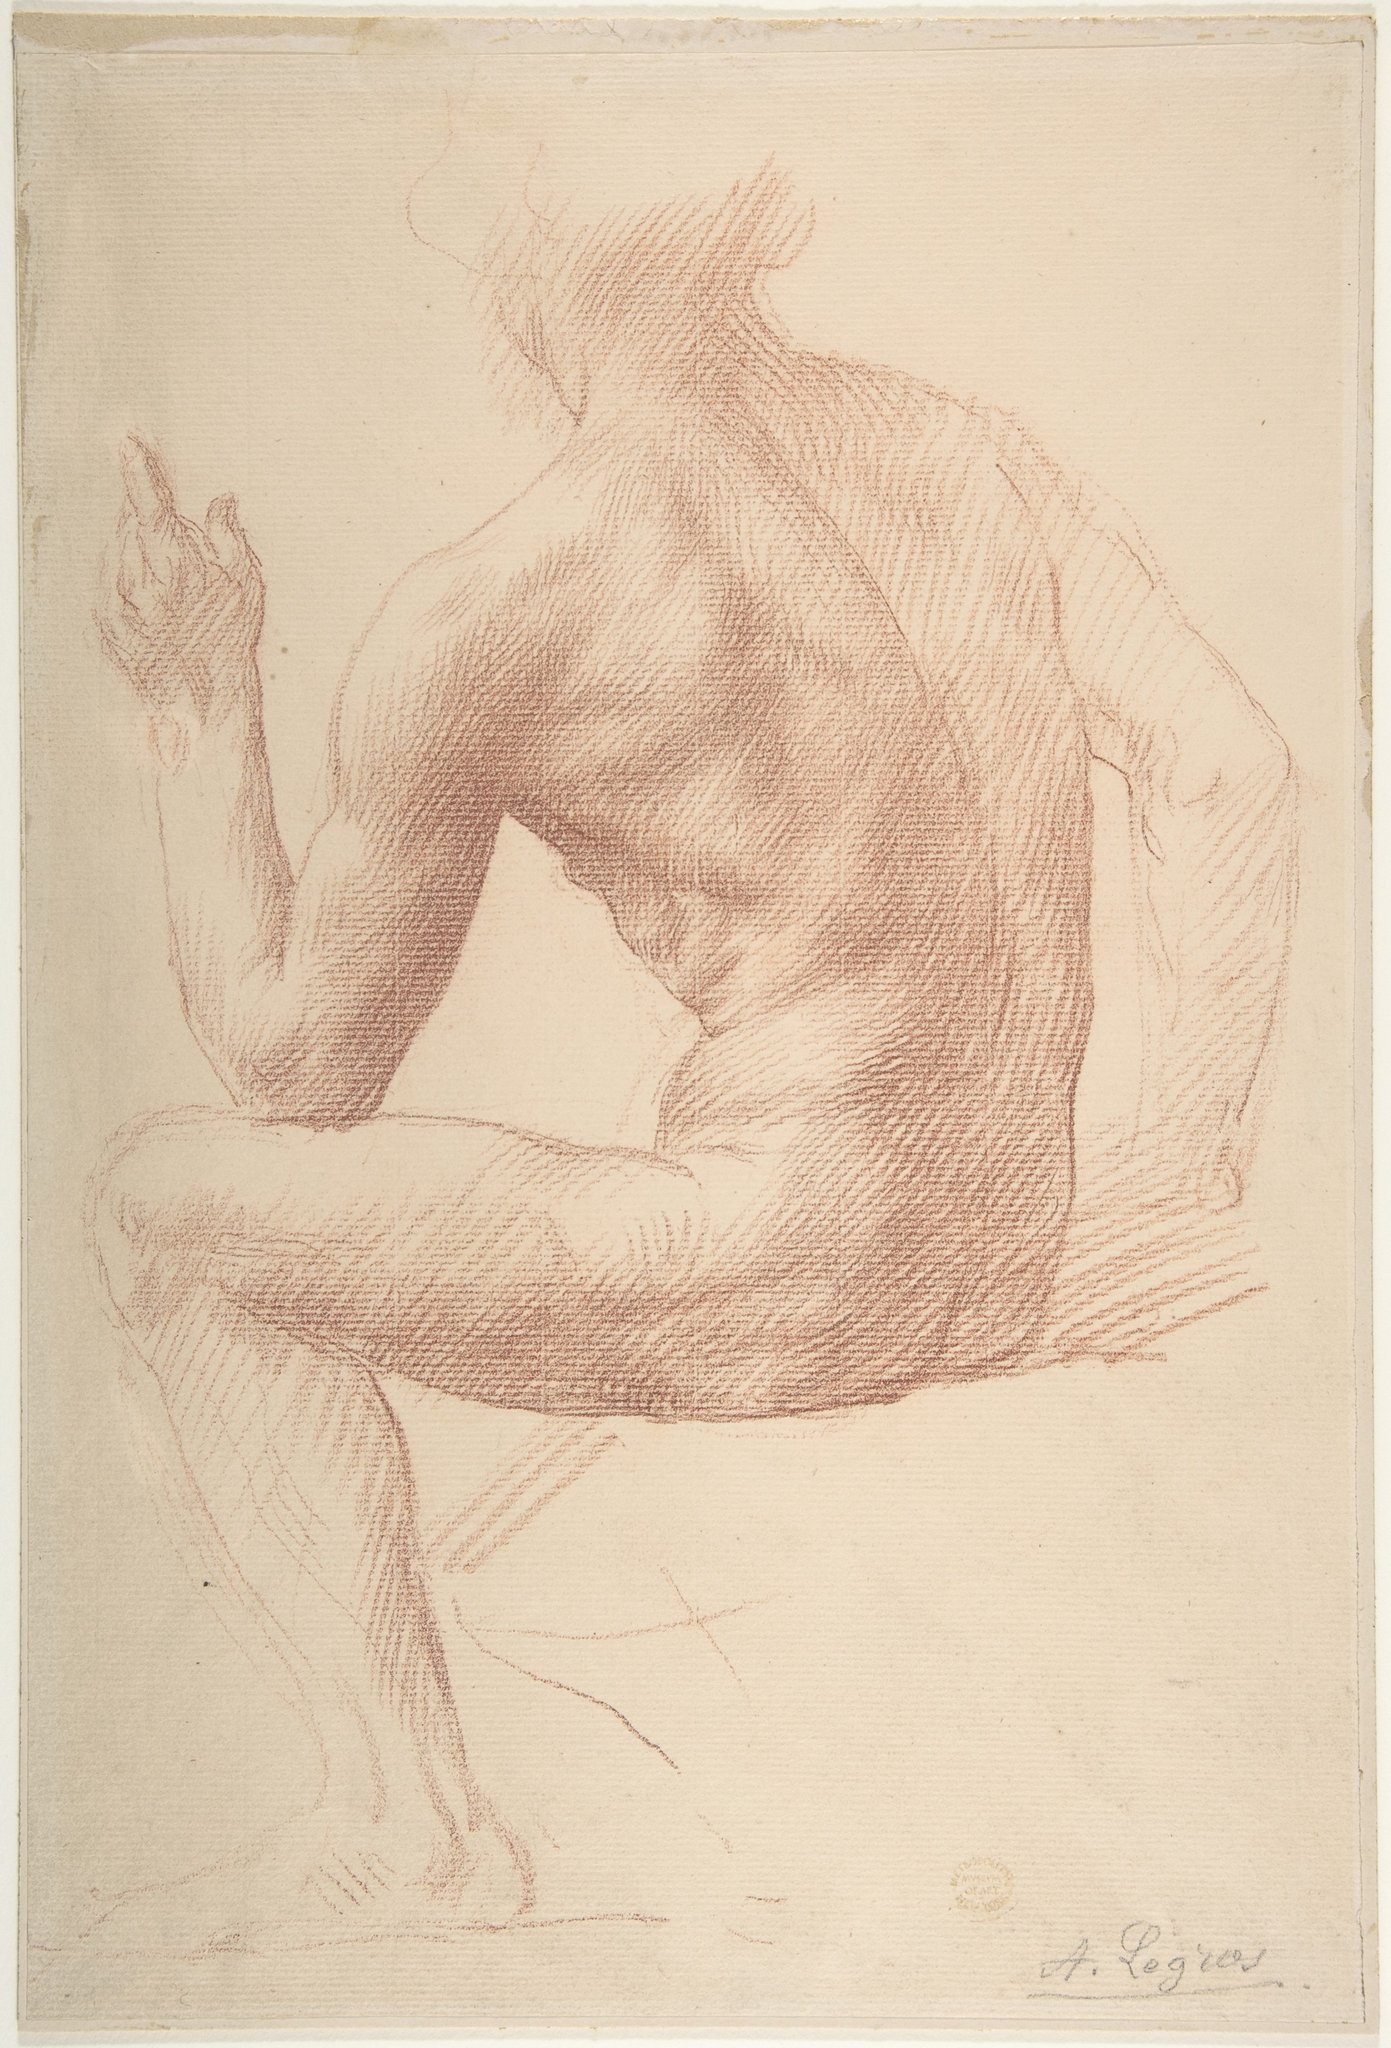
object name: drawing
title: Study of a Figure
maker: alphonse legros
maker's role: artist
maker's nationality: french and british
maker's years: 1837-1911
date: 1837-1911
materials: chalk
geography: france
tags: male nudes